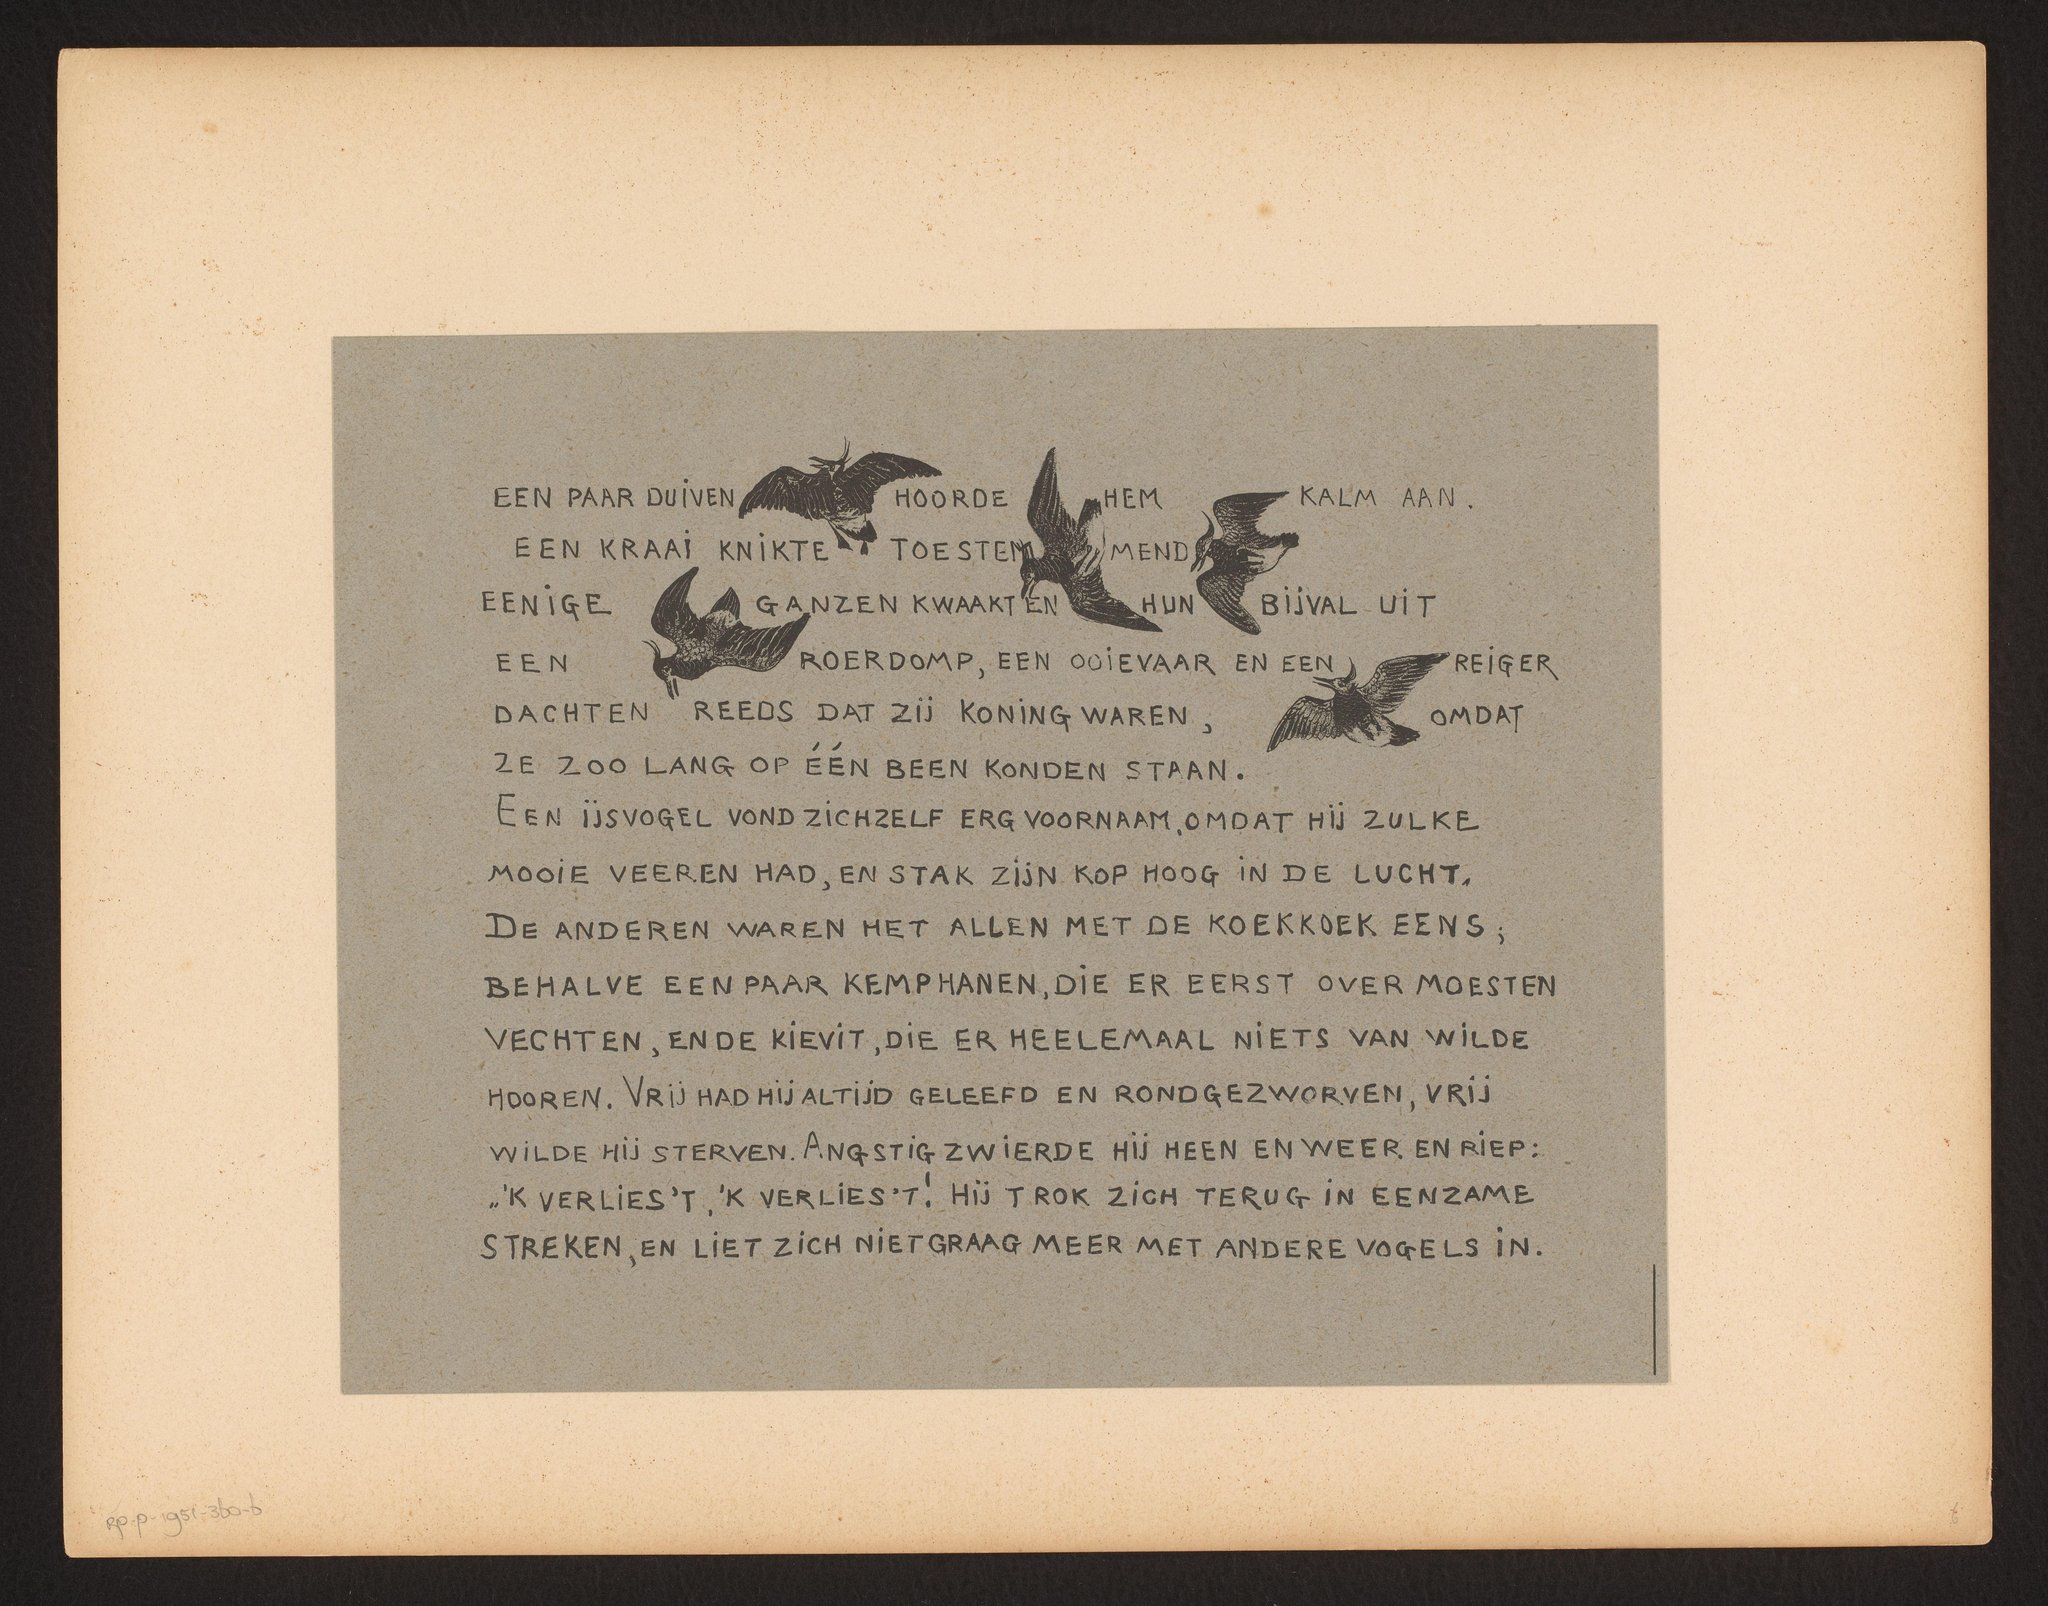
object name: print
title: Hoe de vogels aan een koning kwamen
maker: theo van hoytema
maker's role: draughtsman, painter, print maker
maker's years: 1863-1917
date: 1892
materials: paper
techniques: lithograph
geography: the hague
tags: shore-birds and wading-birds: lapwing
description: Zowel tekst als afbeelding zijn gelithografeerd.